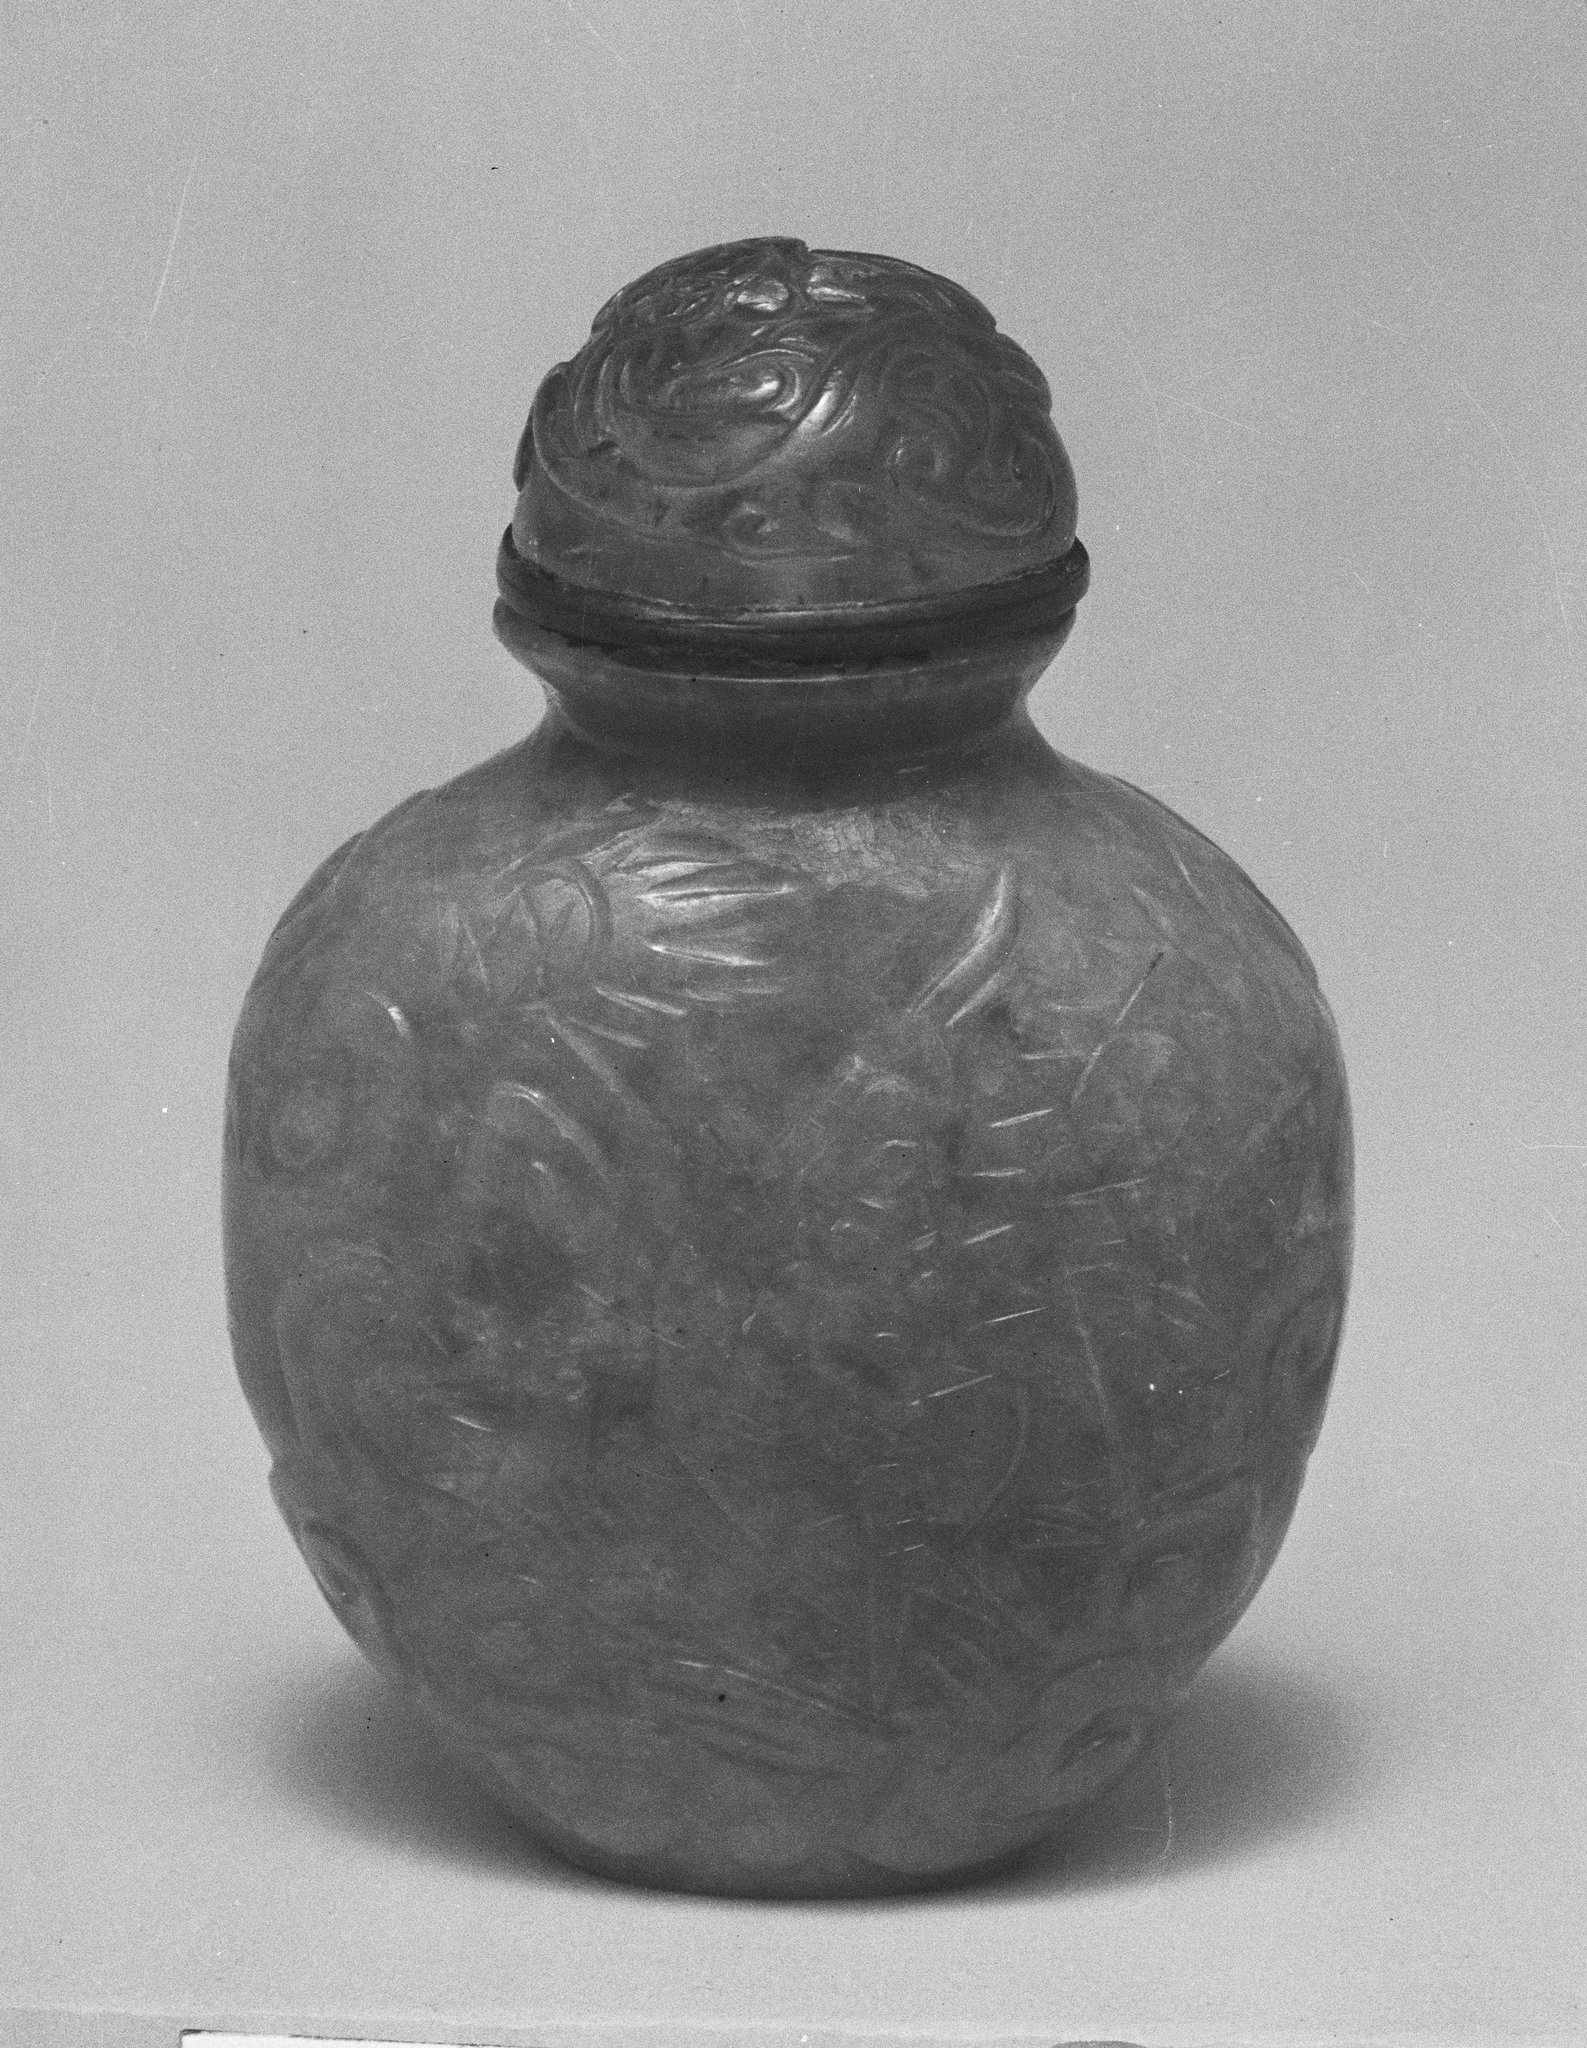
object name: snuff bottle with stopper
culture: chinese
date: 1662-1722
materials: glass, jade